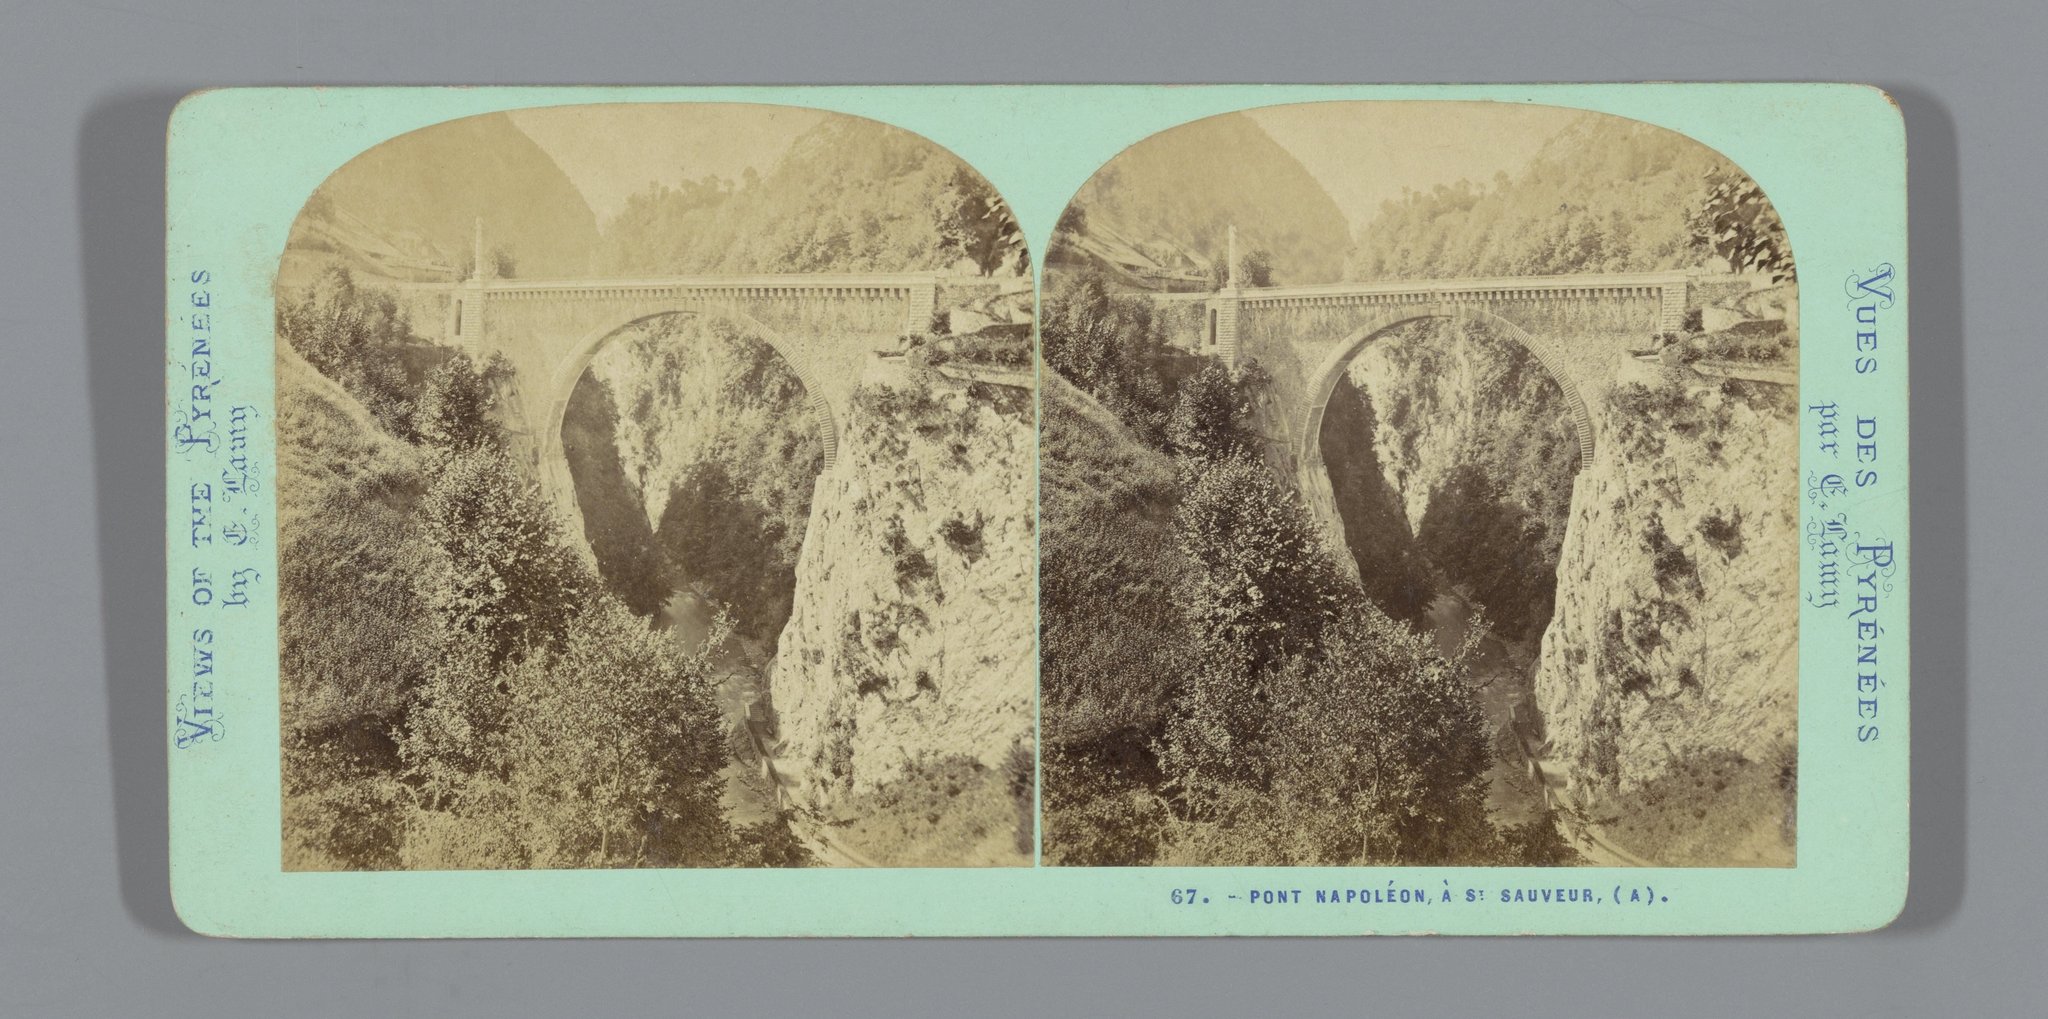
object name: stereograph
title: Pont Napoléon, à St. Saveur,(a)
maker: ernest eléonor pierre lamy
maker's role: publisher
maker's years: 1828-1900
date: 1860-1880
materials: cardboard, photographic support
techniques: albumen print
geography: pyrenees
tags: bridge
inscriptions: number: ‘67.’